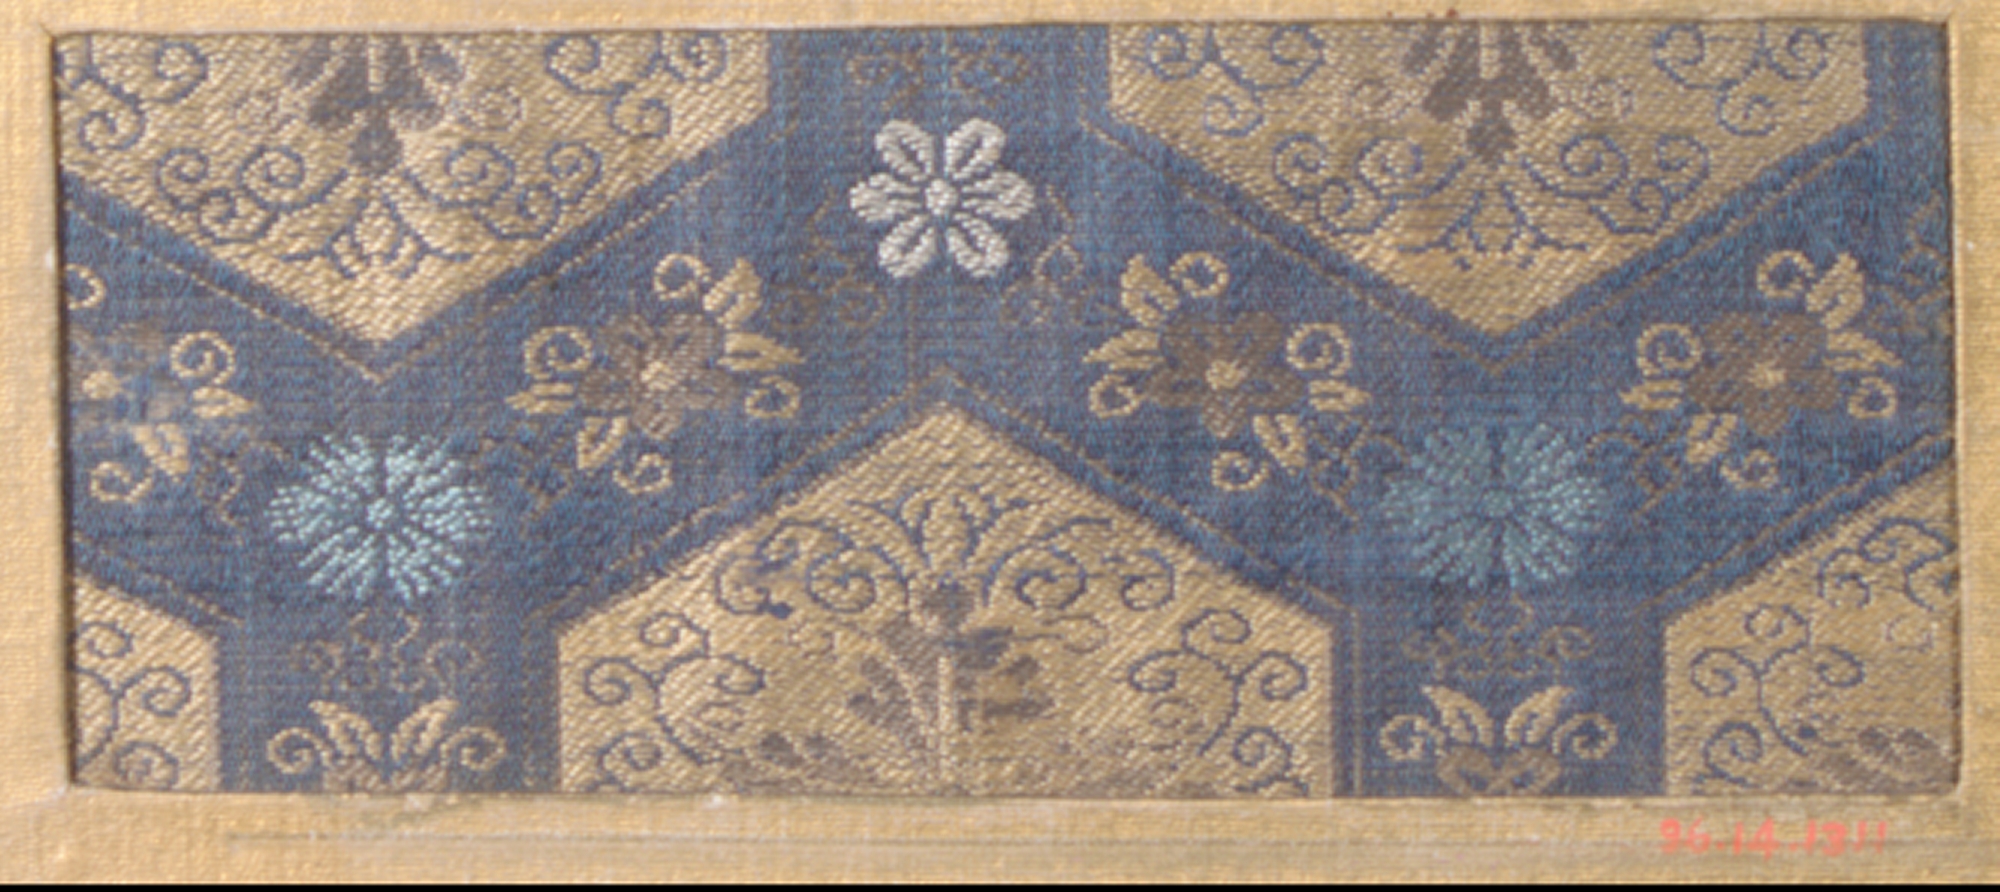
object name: piece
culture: japanese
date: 1701-1900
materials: silk